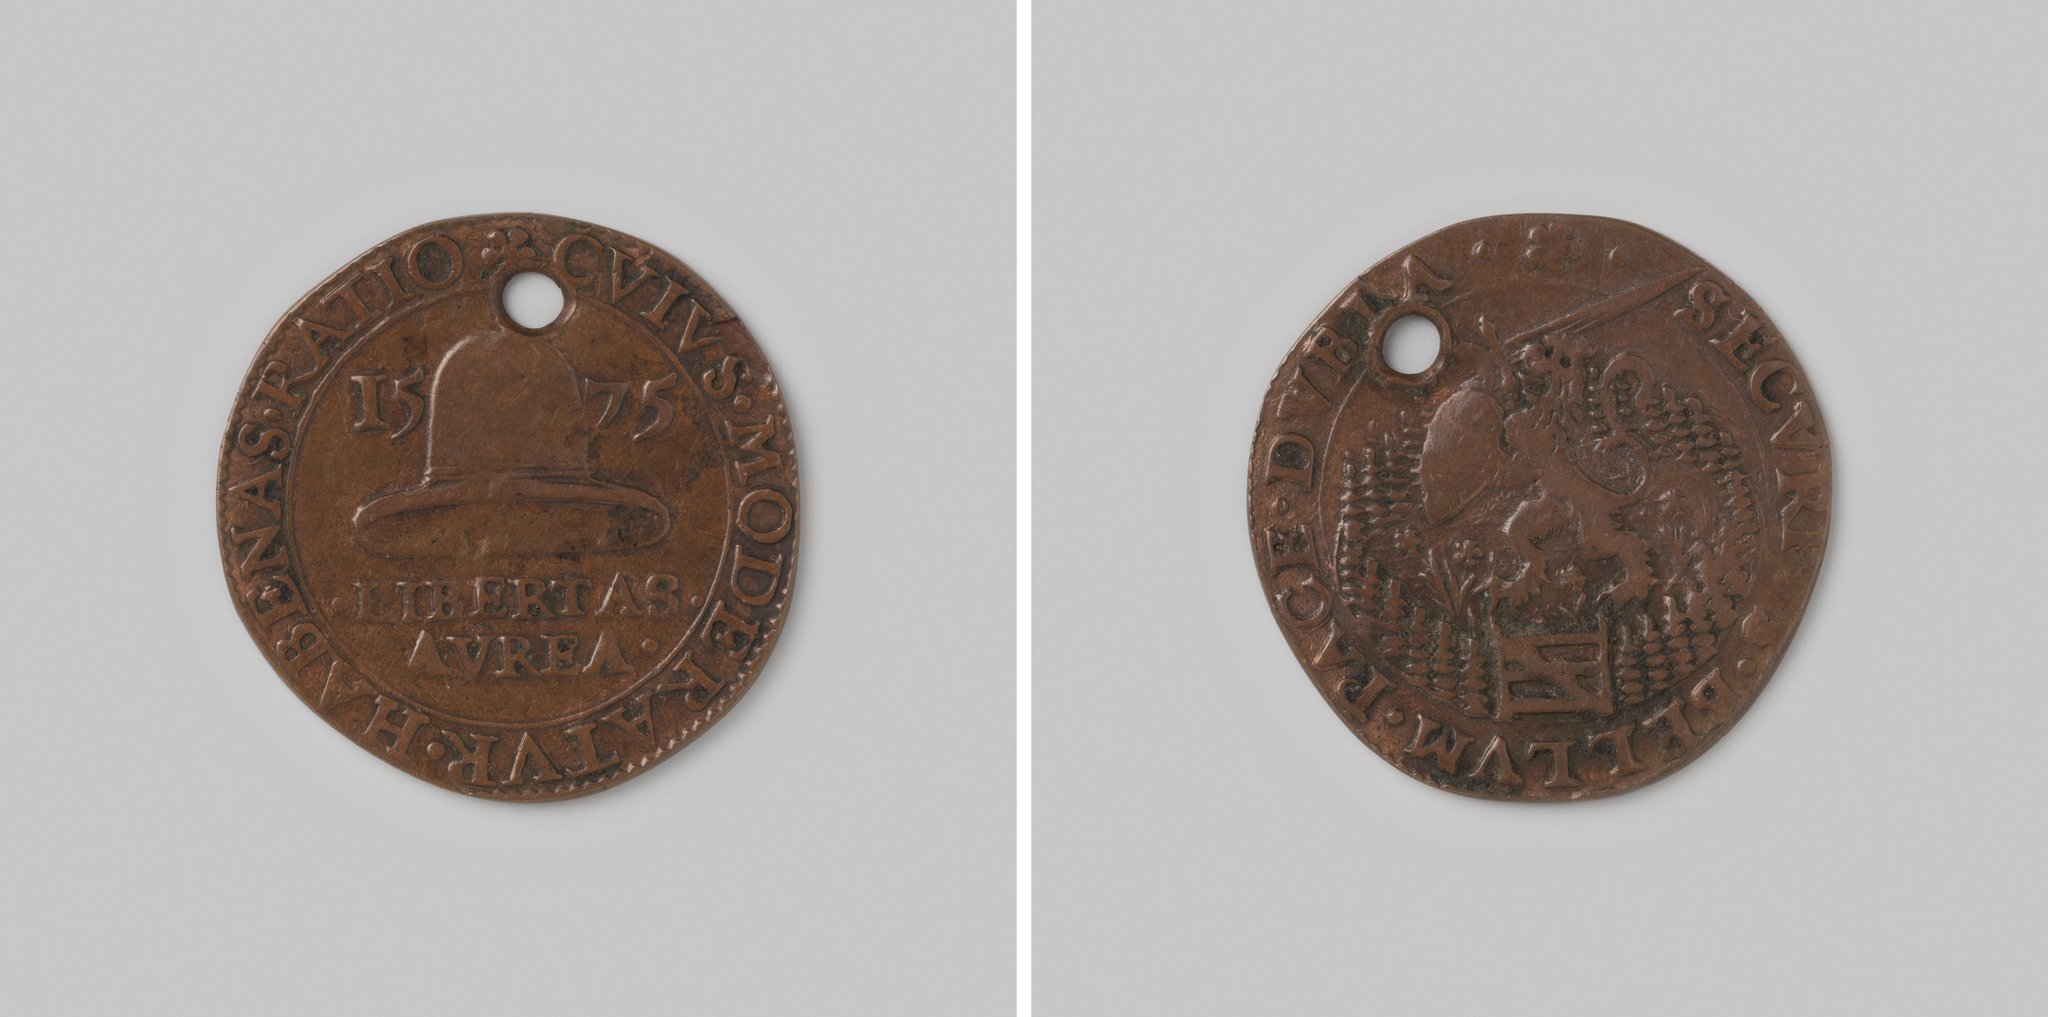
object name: history medal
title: Rekenpenning uit Dordrecht op de het afbreken van de vredesonderhandelingen 1575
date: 1575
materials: copper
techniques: striking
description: Koperen penning met doorboring, op de voorzijde een vrijheidshoed met het jaartal en twee regels tekst, met omschrift, op de keerzijde een klimmende leeuw met zwaard en schild binnen een tuin, met omschrtift.